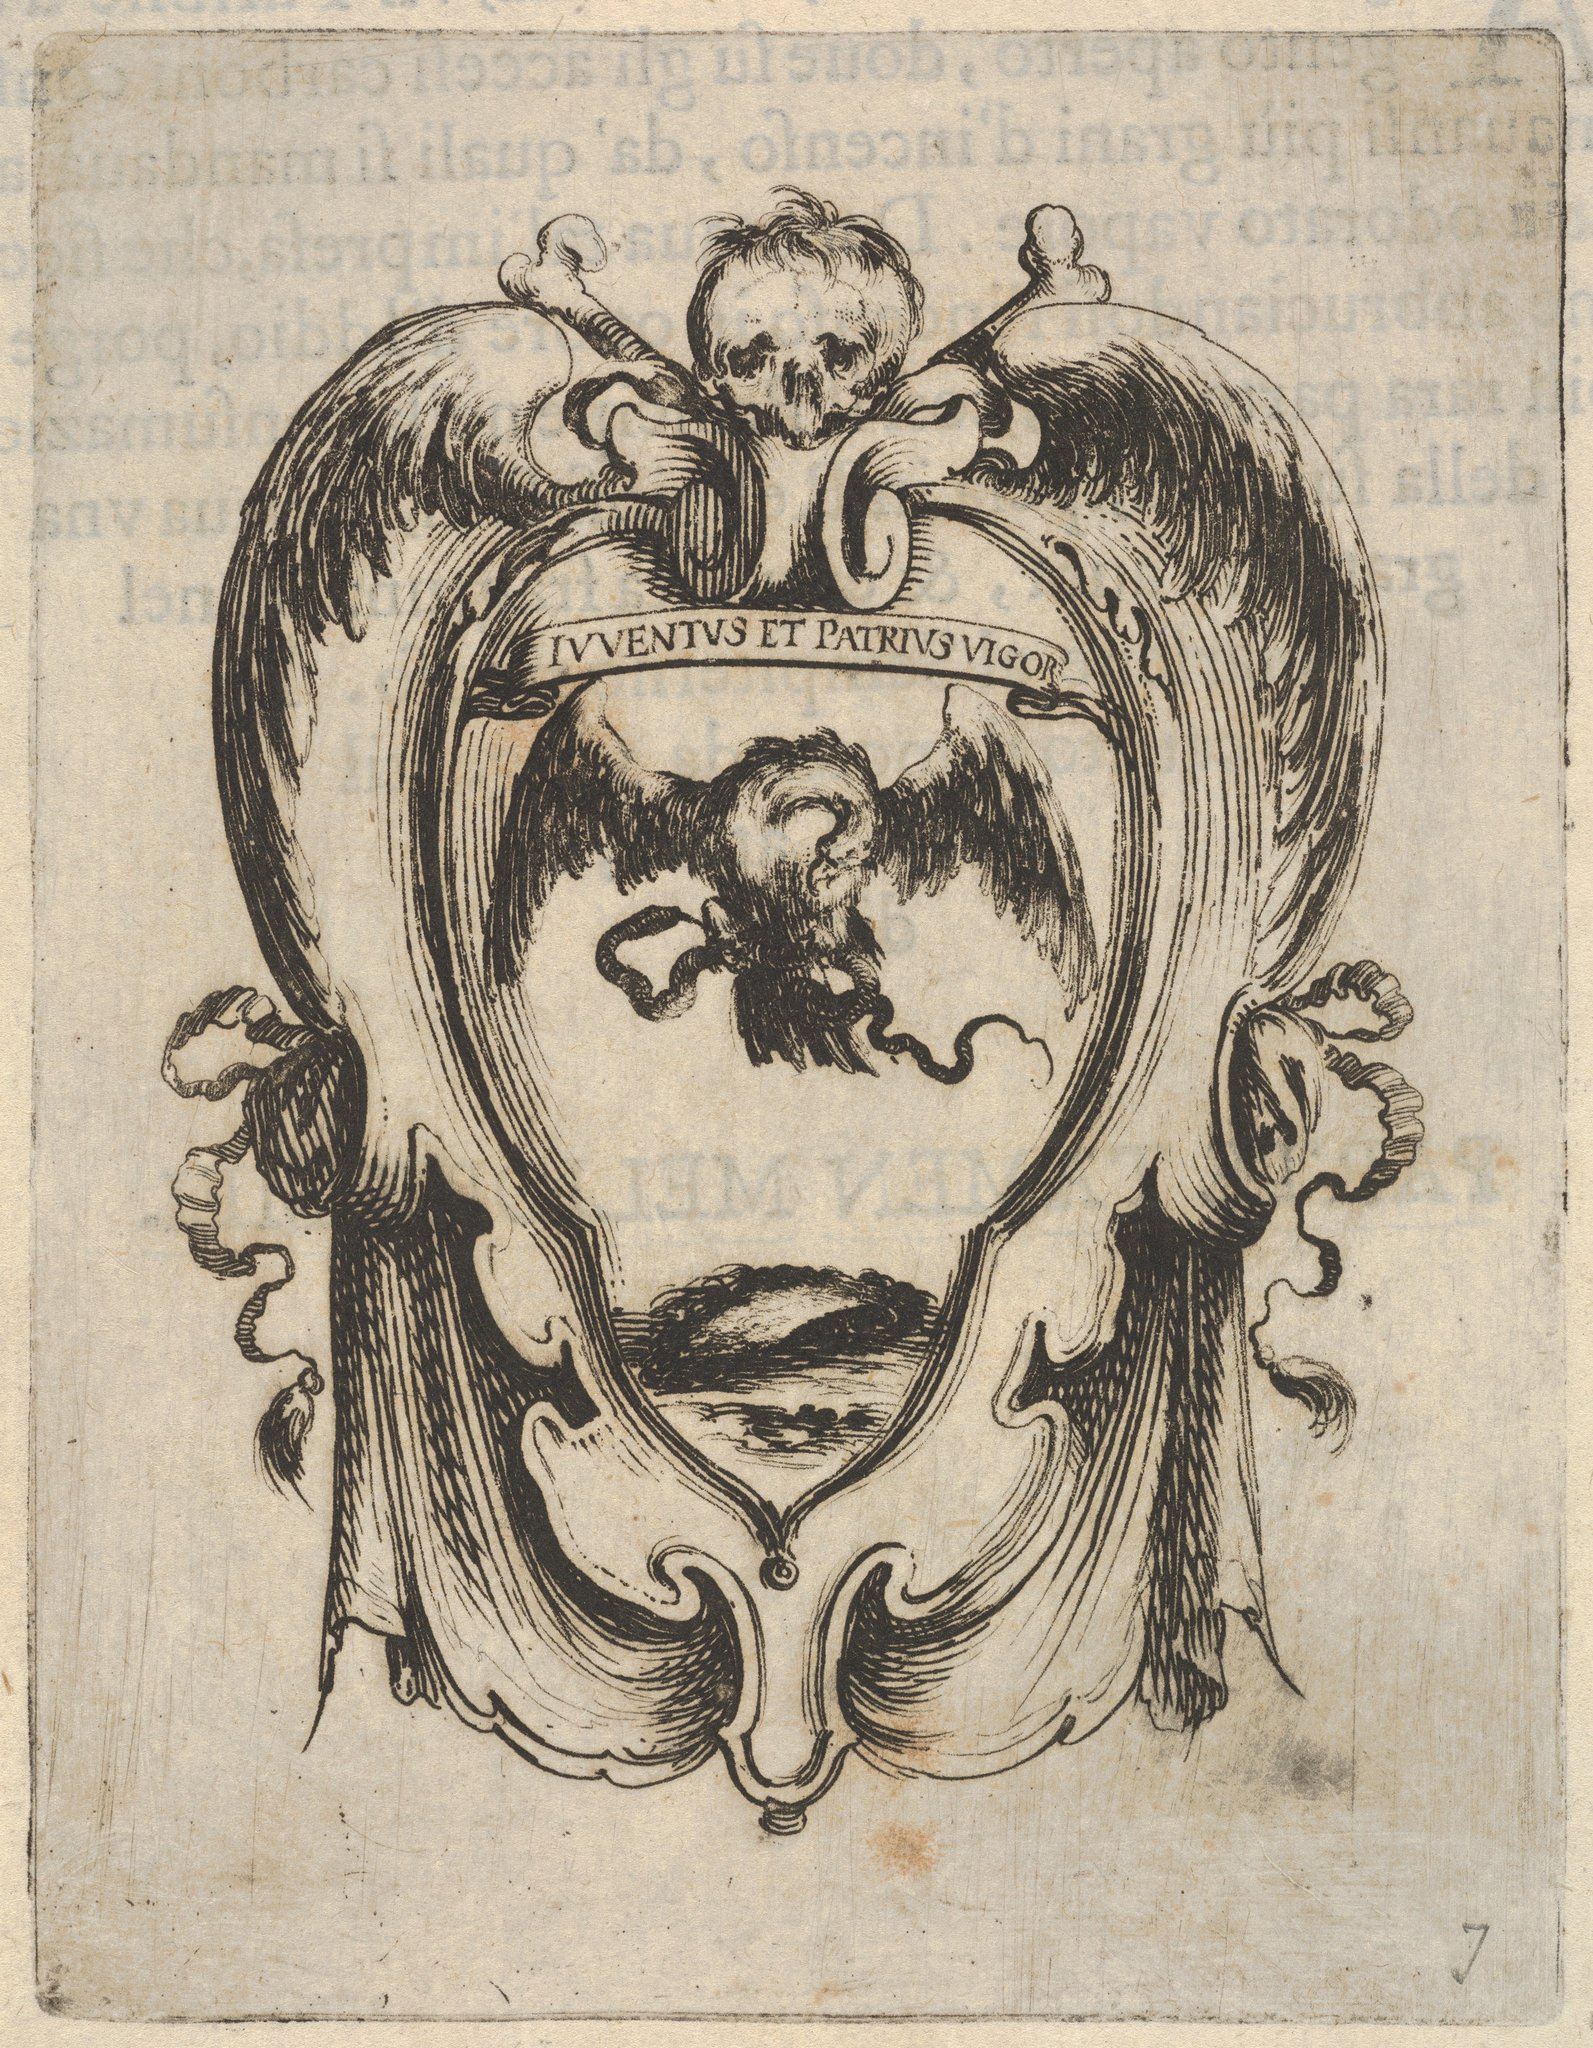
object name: print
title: A cartouche with an eagle and a snake, a skull and crossbones at top, wings to either side, from "Eight Emblems for the Funeral of Francesco de Medici" (Huit emblèmes pour les funérailles du prince François de Médicis)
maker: stefano della bella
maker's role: artist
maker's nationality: italian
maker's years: 1610-1664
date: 1640-1660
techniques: etching, letterpress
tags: eagles,cartouches,skulls,snakes